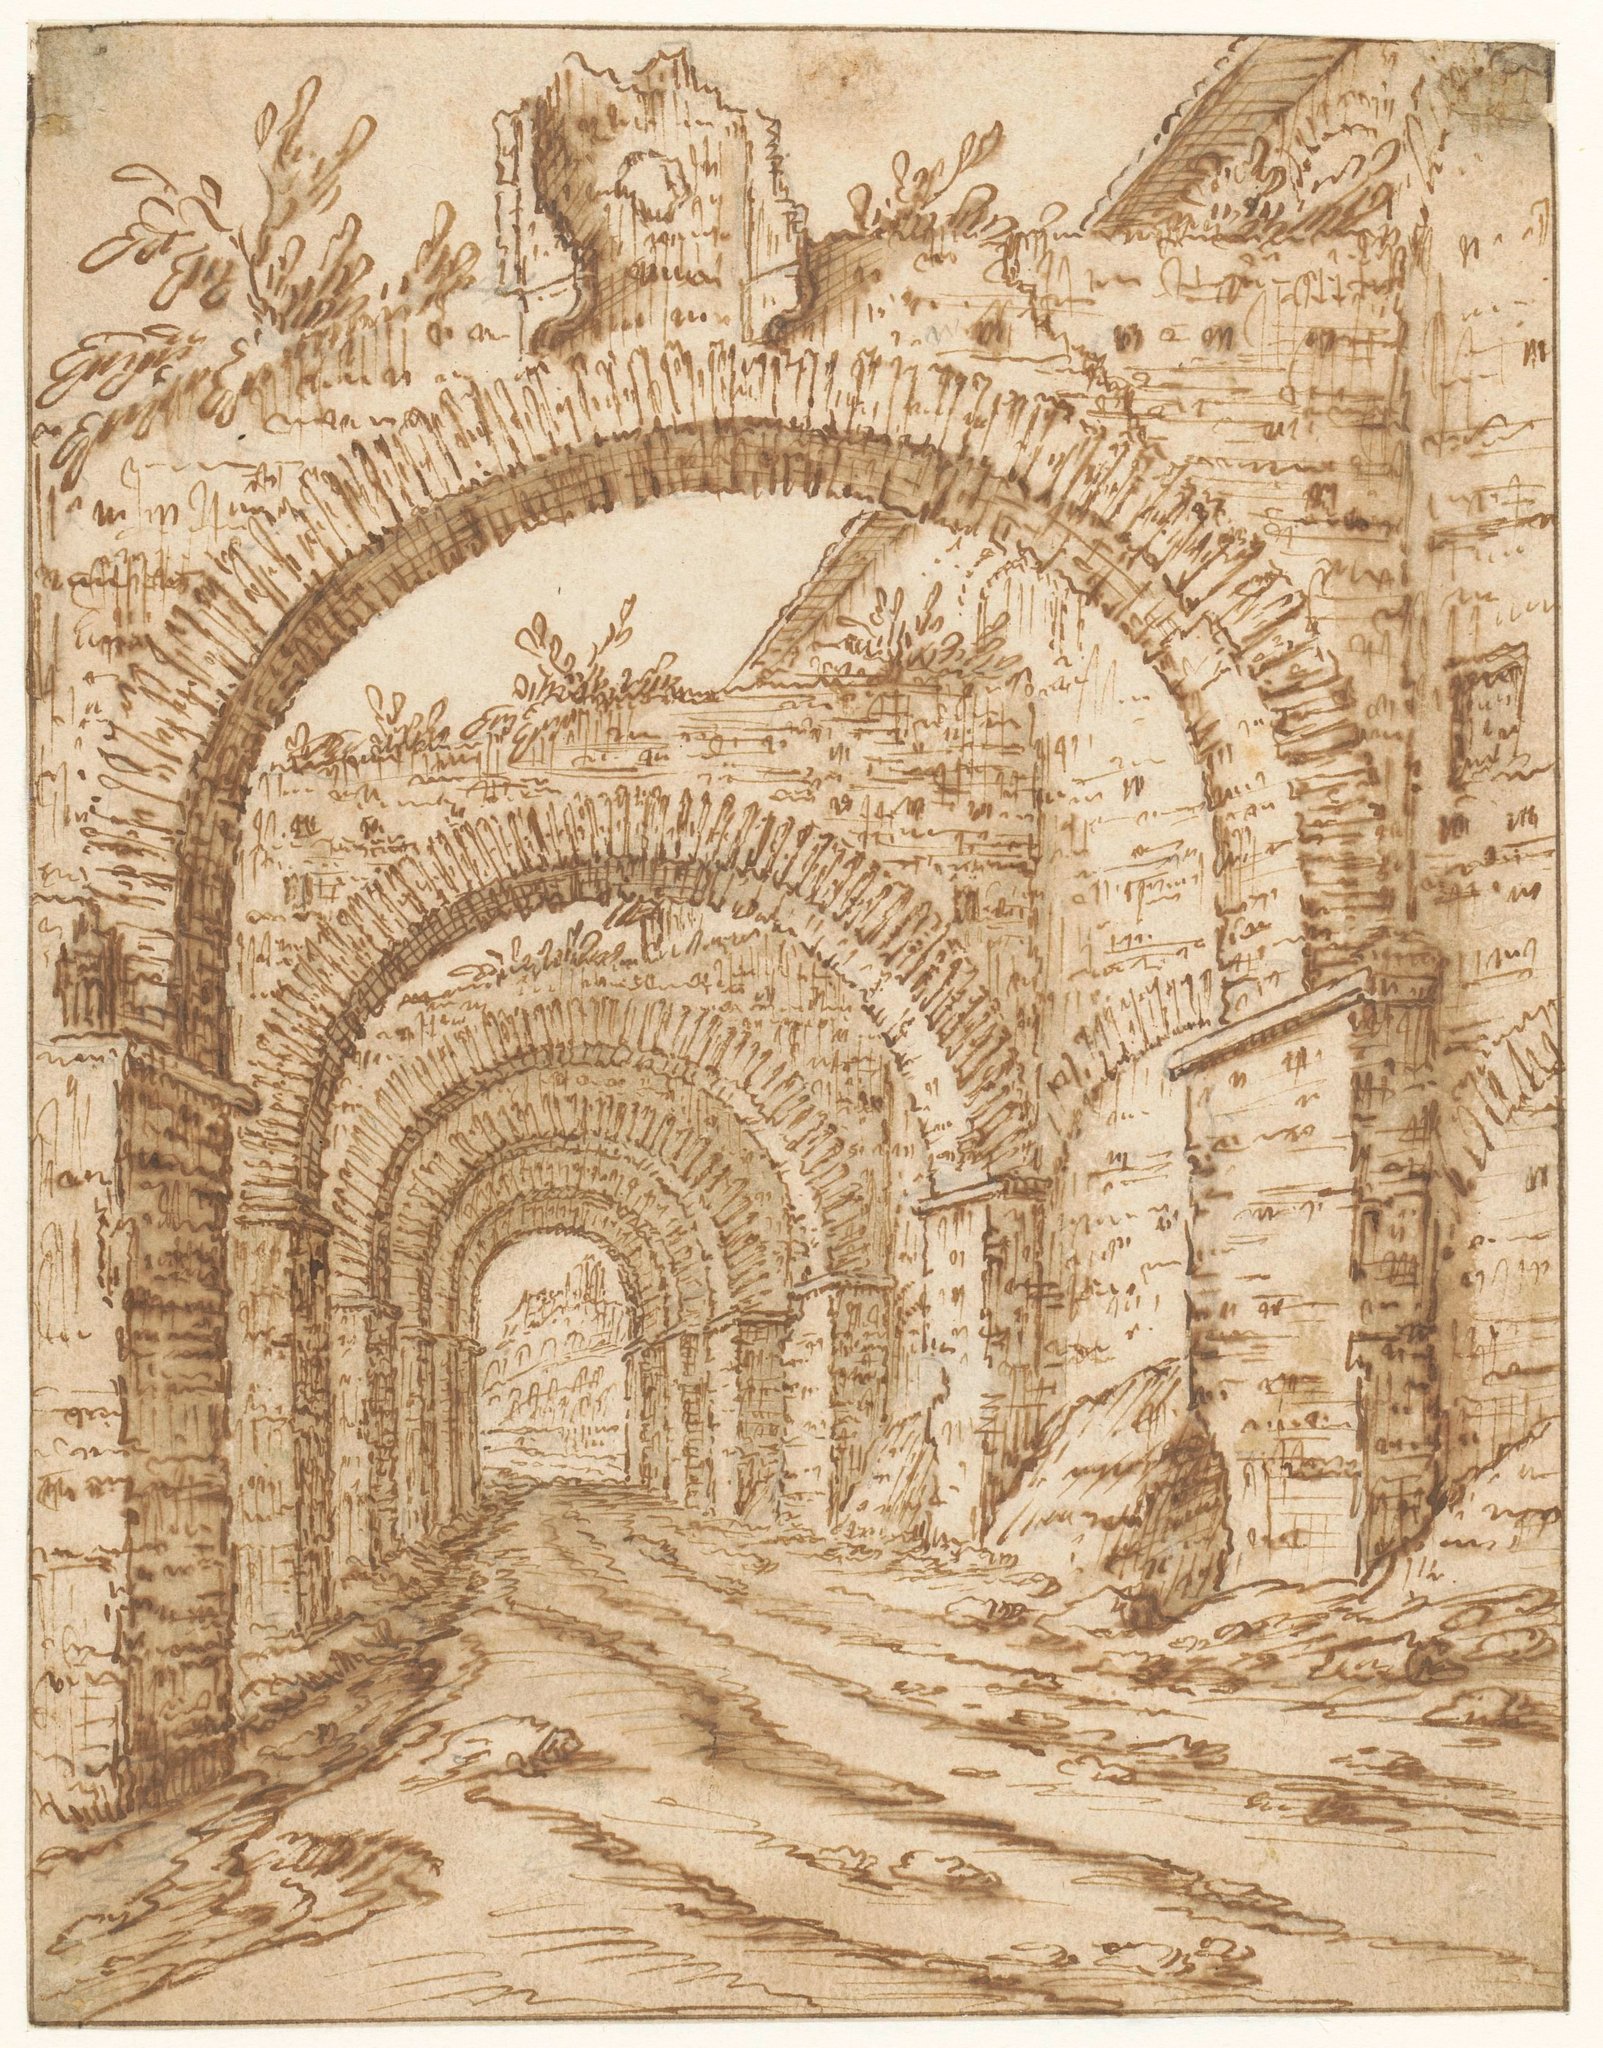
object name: drawing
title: De Clivus Scauri te Rome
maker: tobias verhaecht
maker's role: draughtsman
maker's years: 1561-1631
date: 1571-1590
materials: chalk, graphite, ink, paper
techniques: brush, pen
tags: arcade ~ architecture, public road